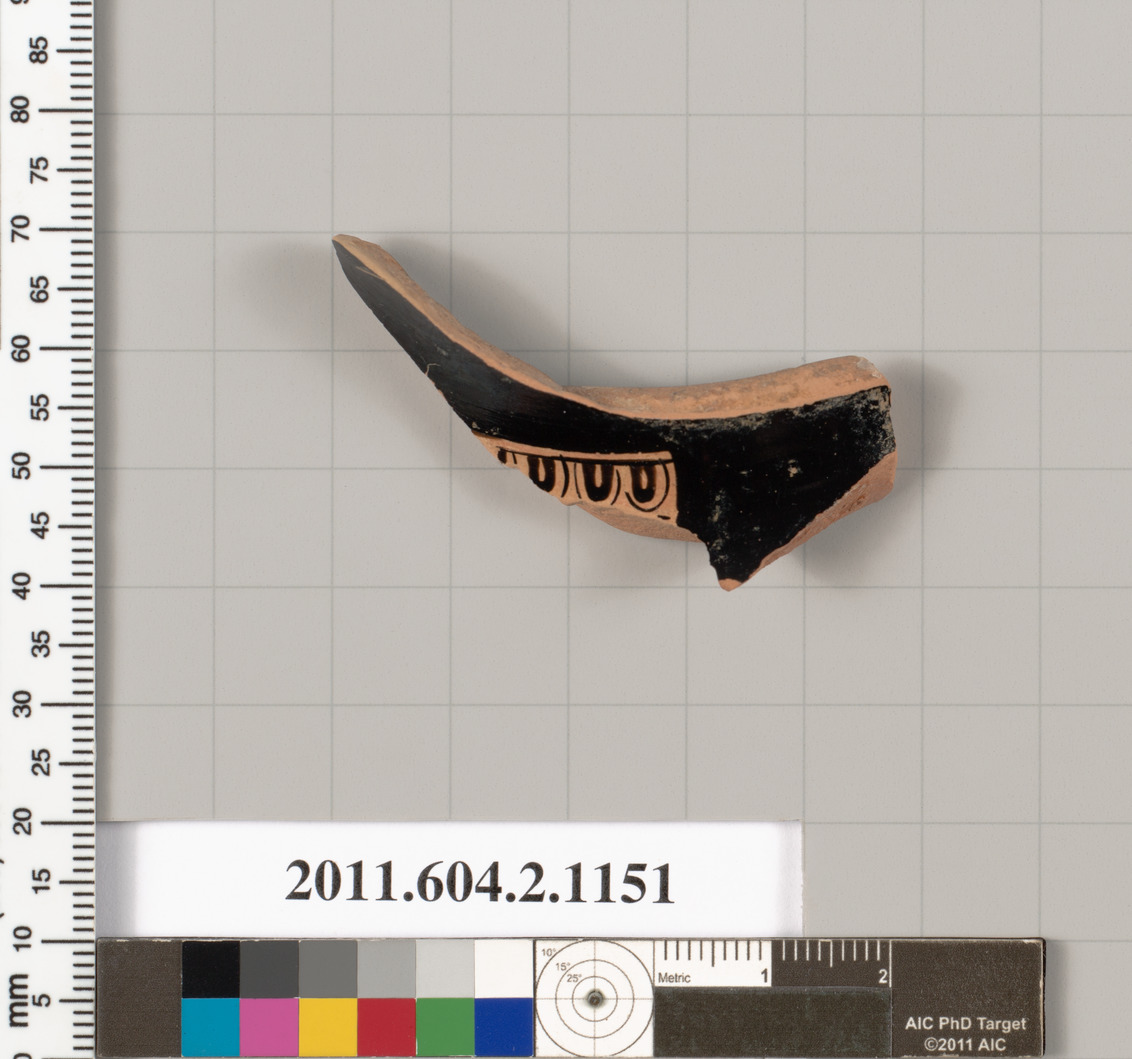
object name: chou fragment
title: Terracotta fragment of an oinochoe: chous (jug)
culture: greek, attic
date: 425-401 BCE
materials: terracotta